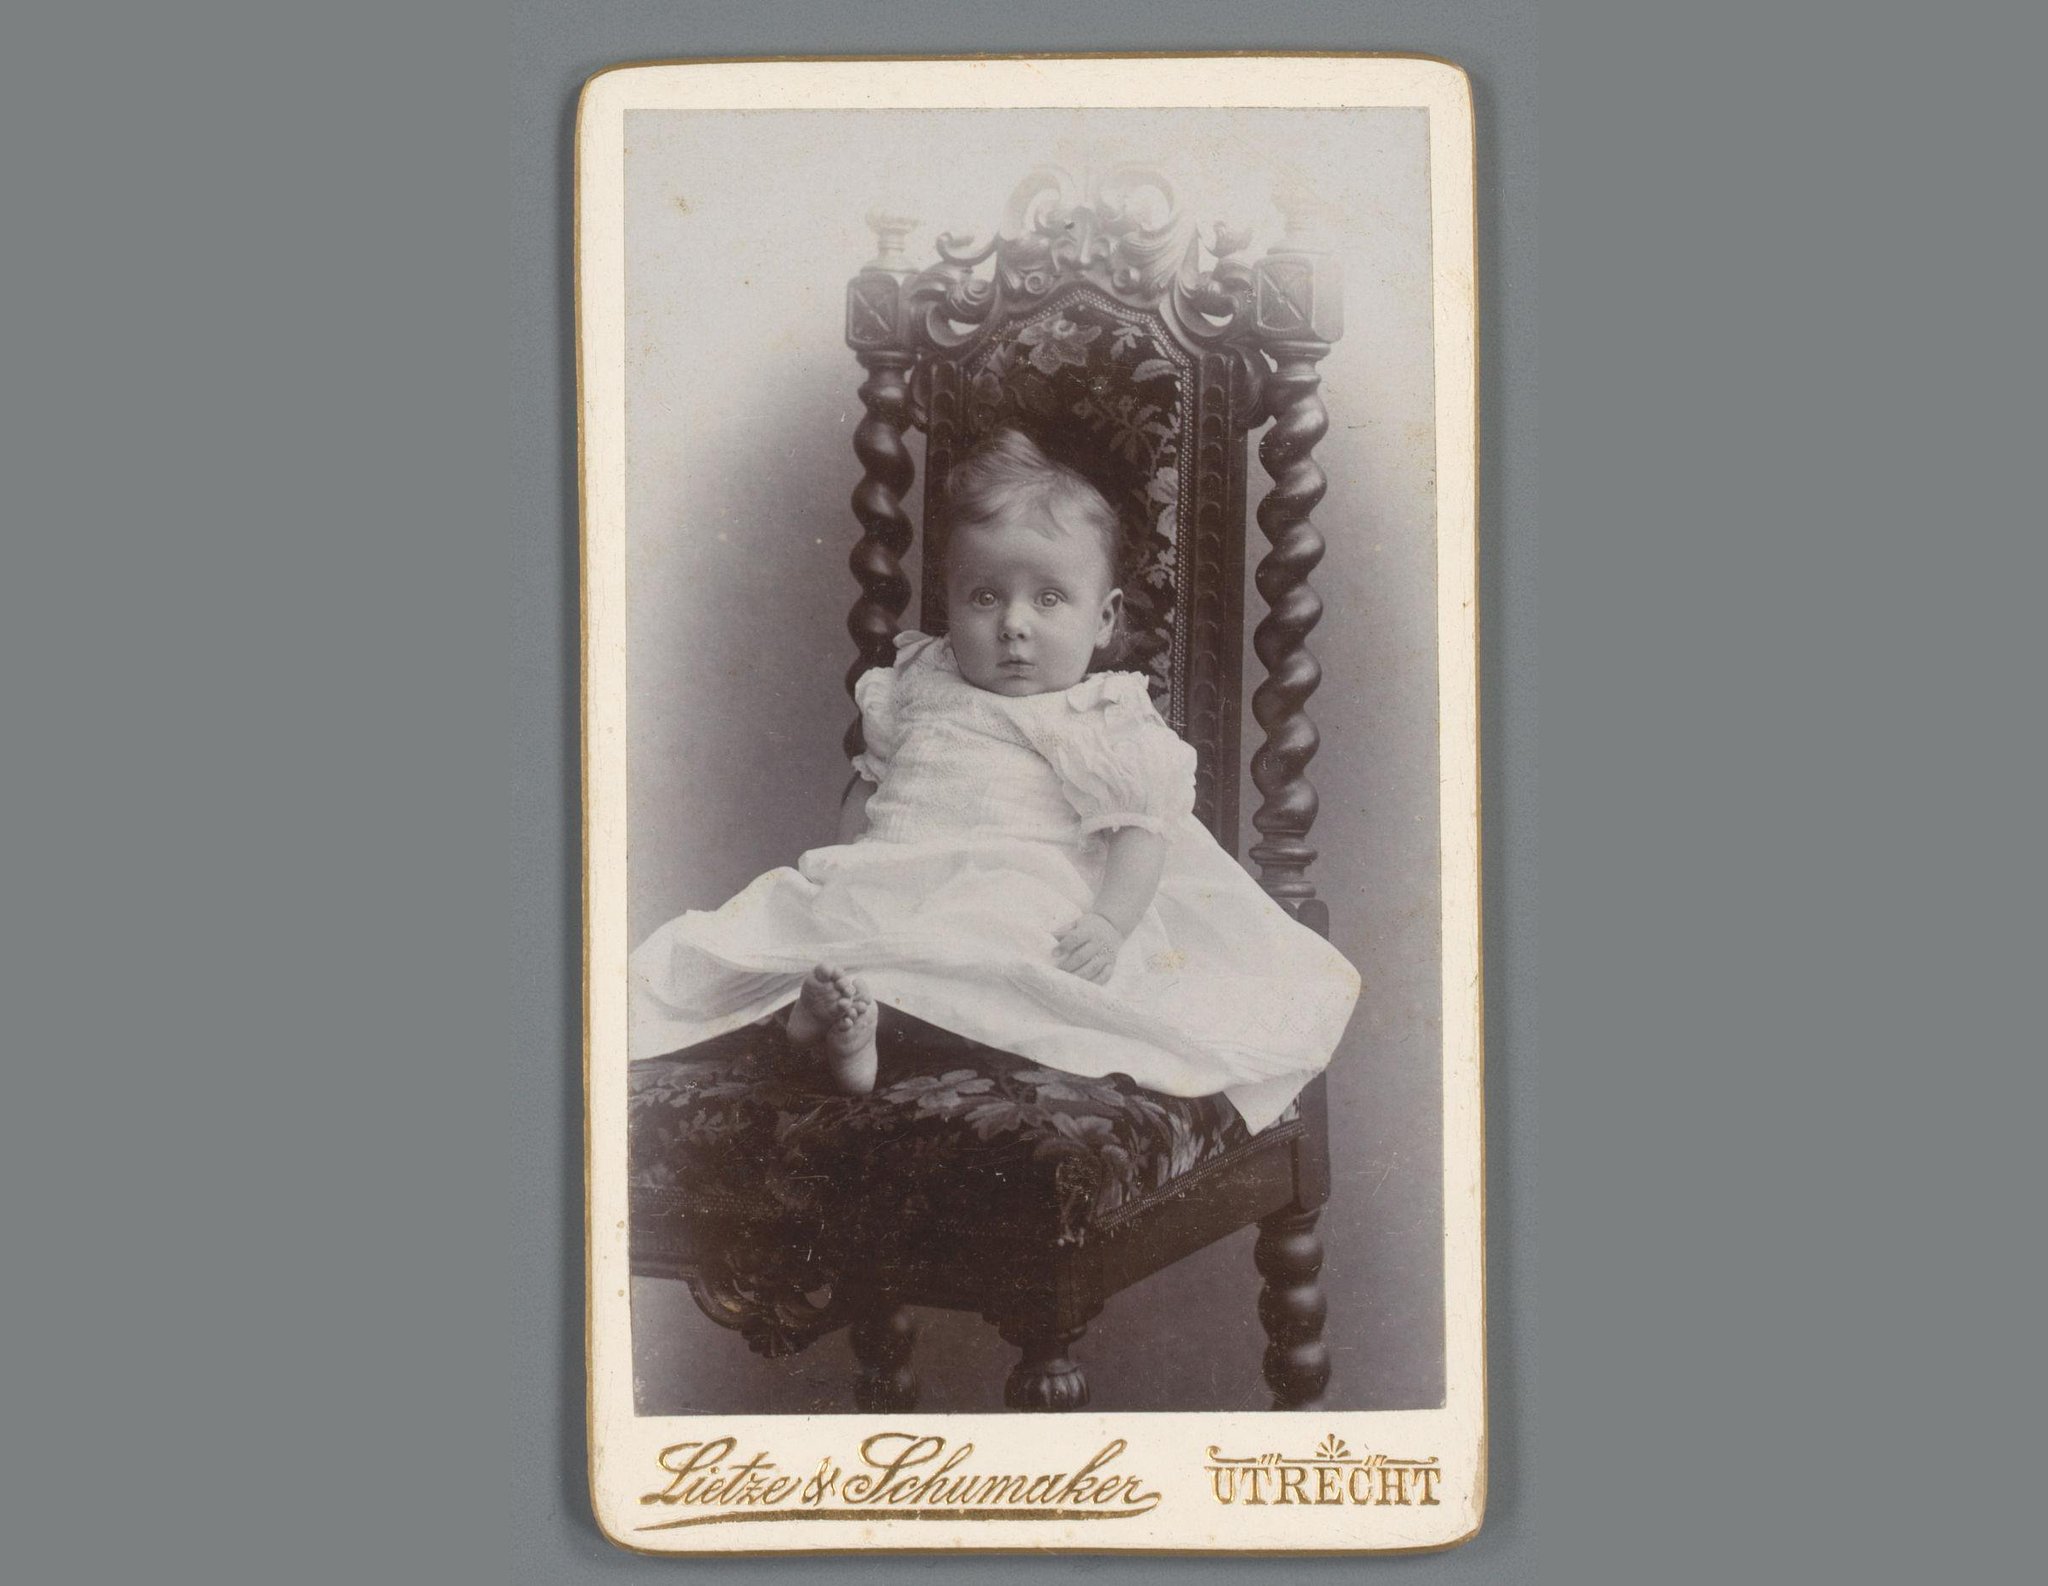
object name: carte de visite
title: Portret van een baby, aangeduid als Lutje Onnen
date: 1890-1904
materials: paper, cardboard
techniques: collodion silver print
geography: utrecht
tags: historical persons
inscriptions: address: ‘voorheen G.L. Mulder/ van Wijckskade No 22, Hoek Noorderstraat, UTRECHT’